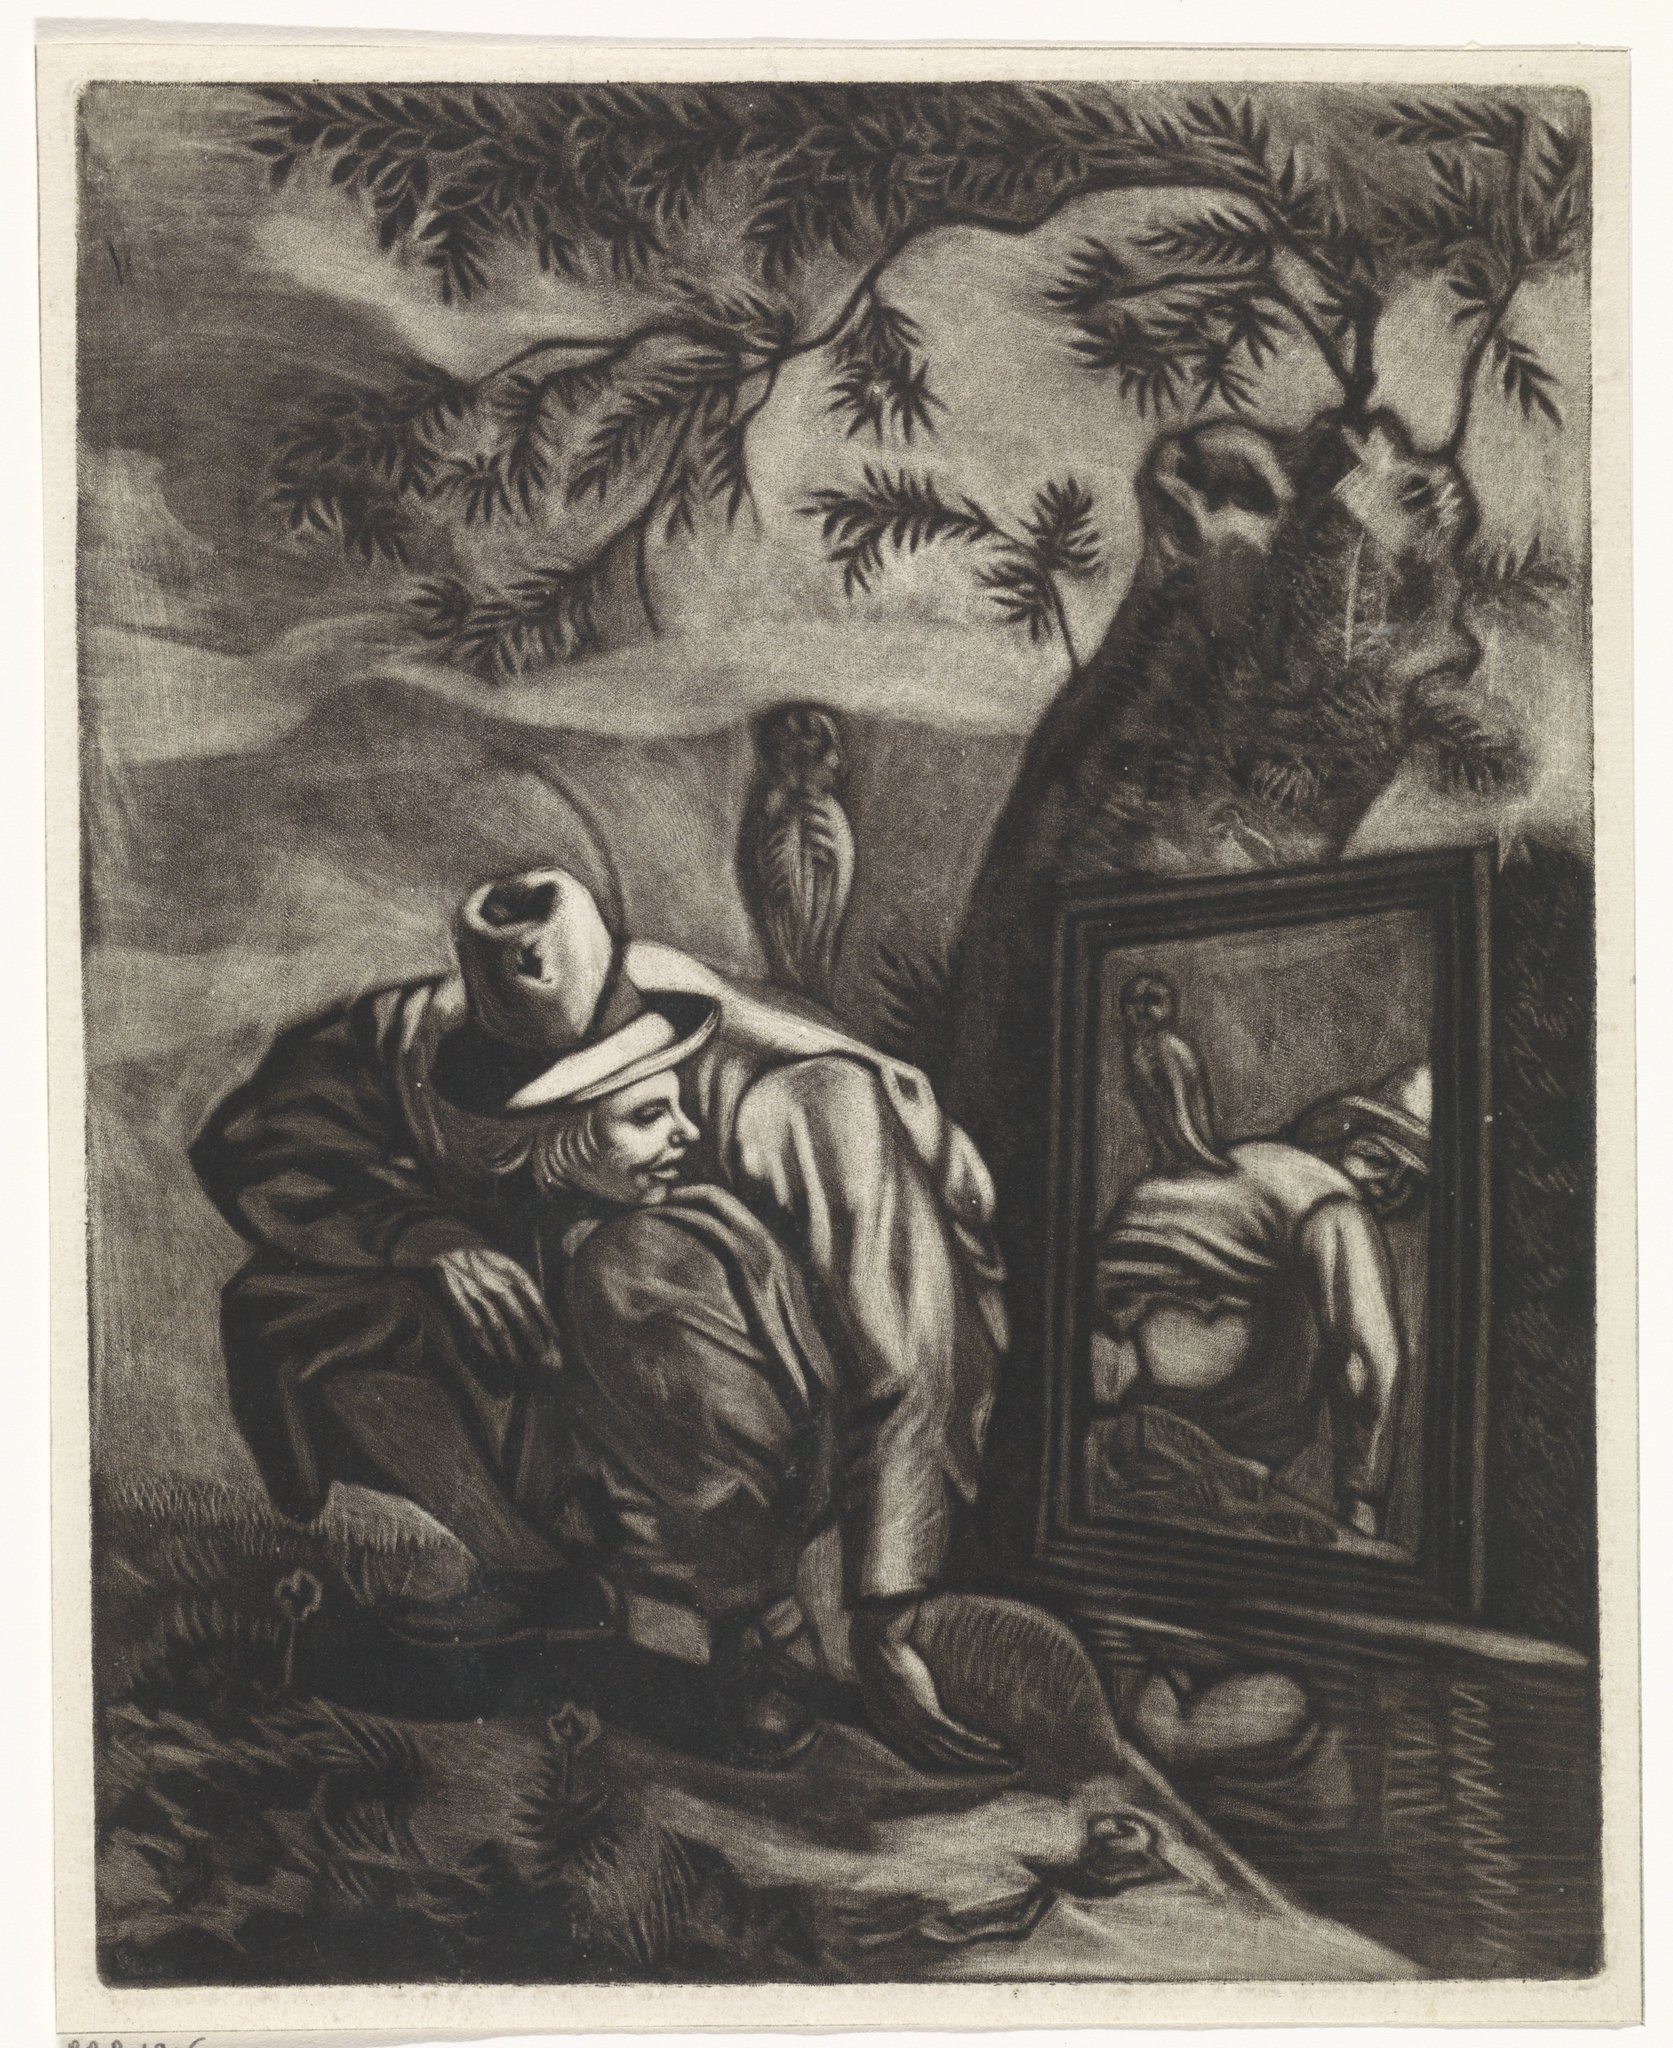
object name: print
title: Gehurkte man voor een spiegel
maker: johannes de groot (ii)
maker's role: painter, print maker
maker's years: 1688-1796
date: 1698-1776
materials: paper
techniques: mezzotint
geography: northern netherlands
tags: mirror, owls, defecation - aa - female human figure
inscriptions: collector's mark: Lugt 2228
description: In een landschap doet een man, gehurkt voor een spiegel, zijn behoefte. Op zijn rug zit een uil.